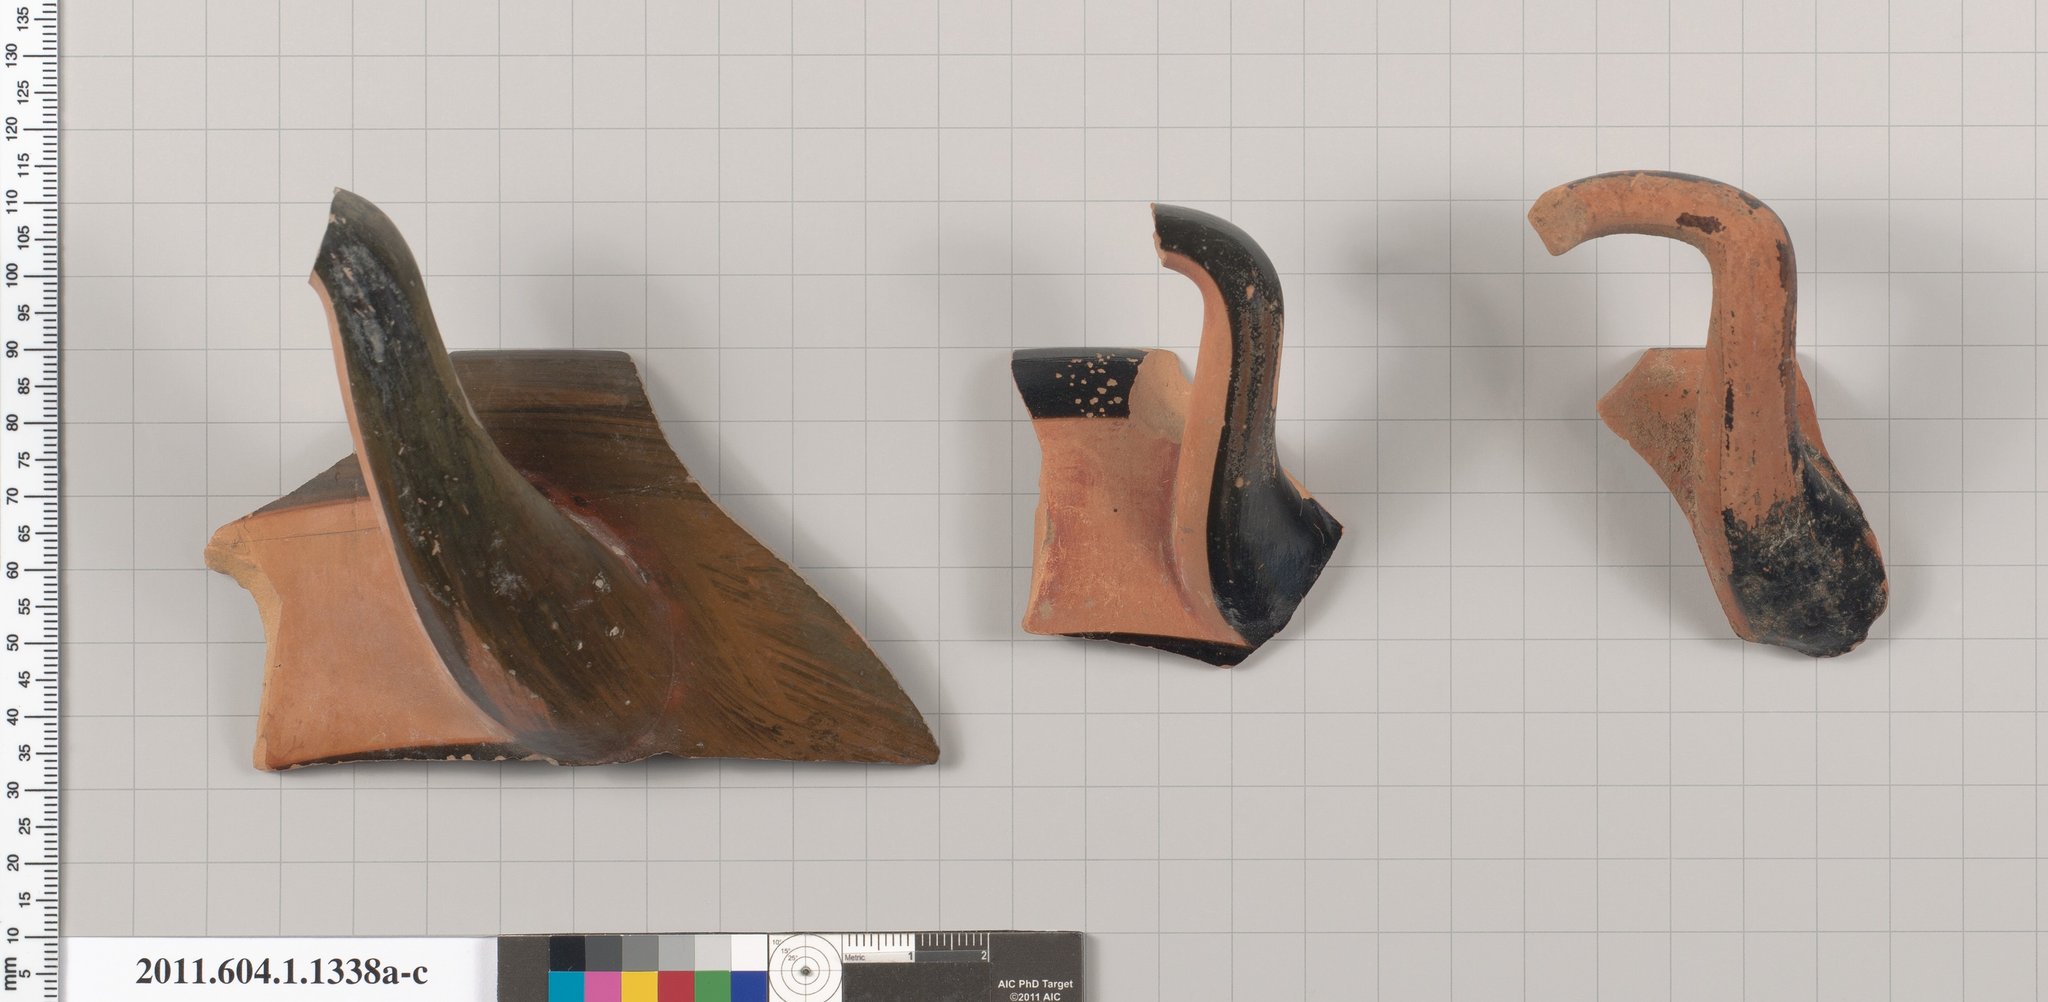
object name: kylix fragment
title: Terracotta fragments of kylikes (drinking cups)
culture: greek, attic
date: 500-401 BCE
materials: terracotta